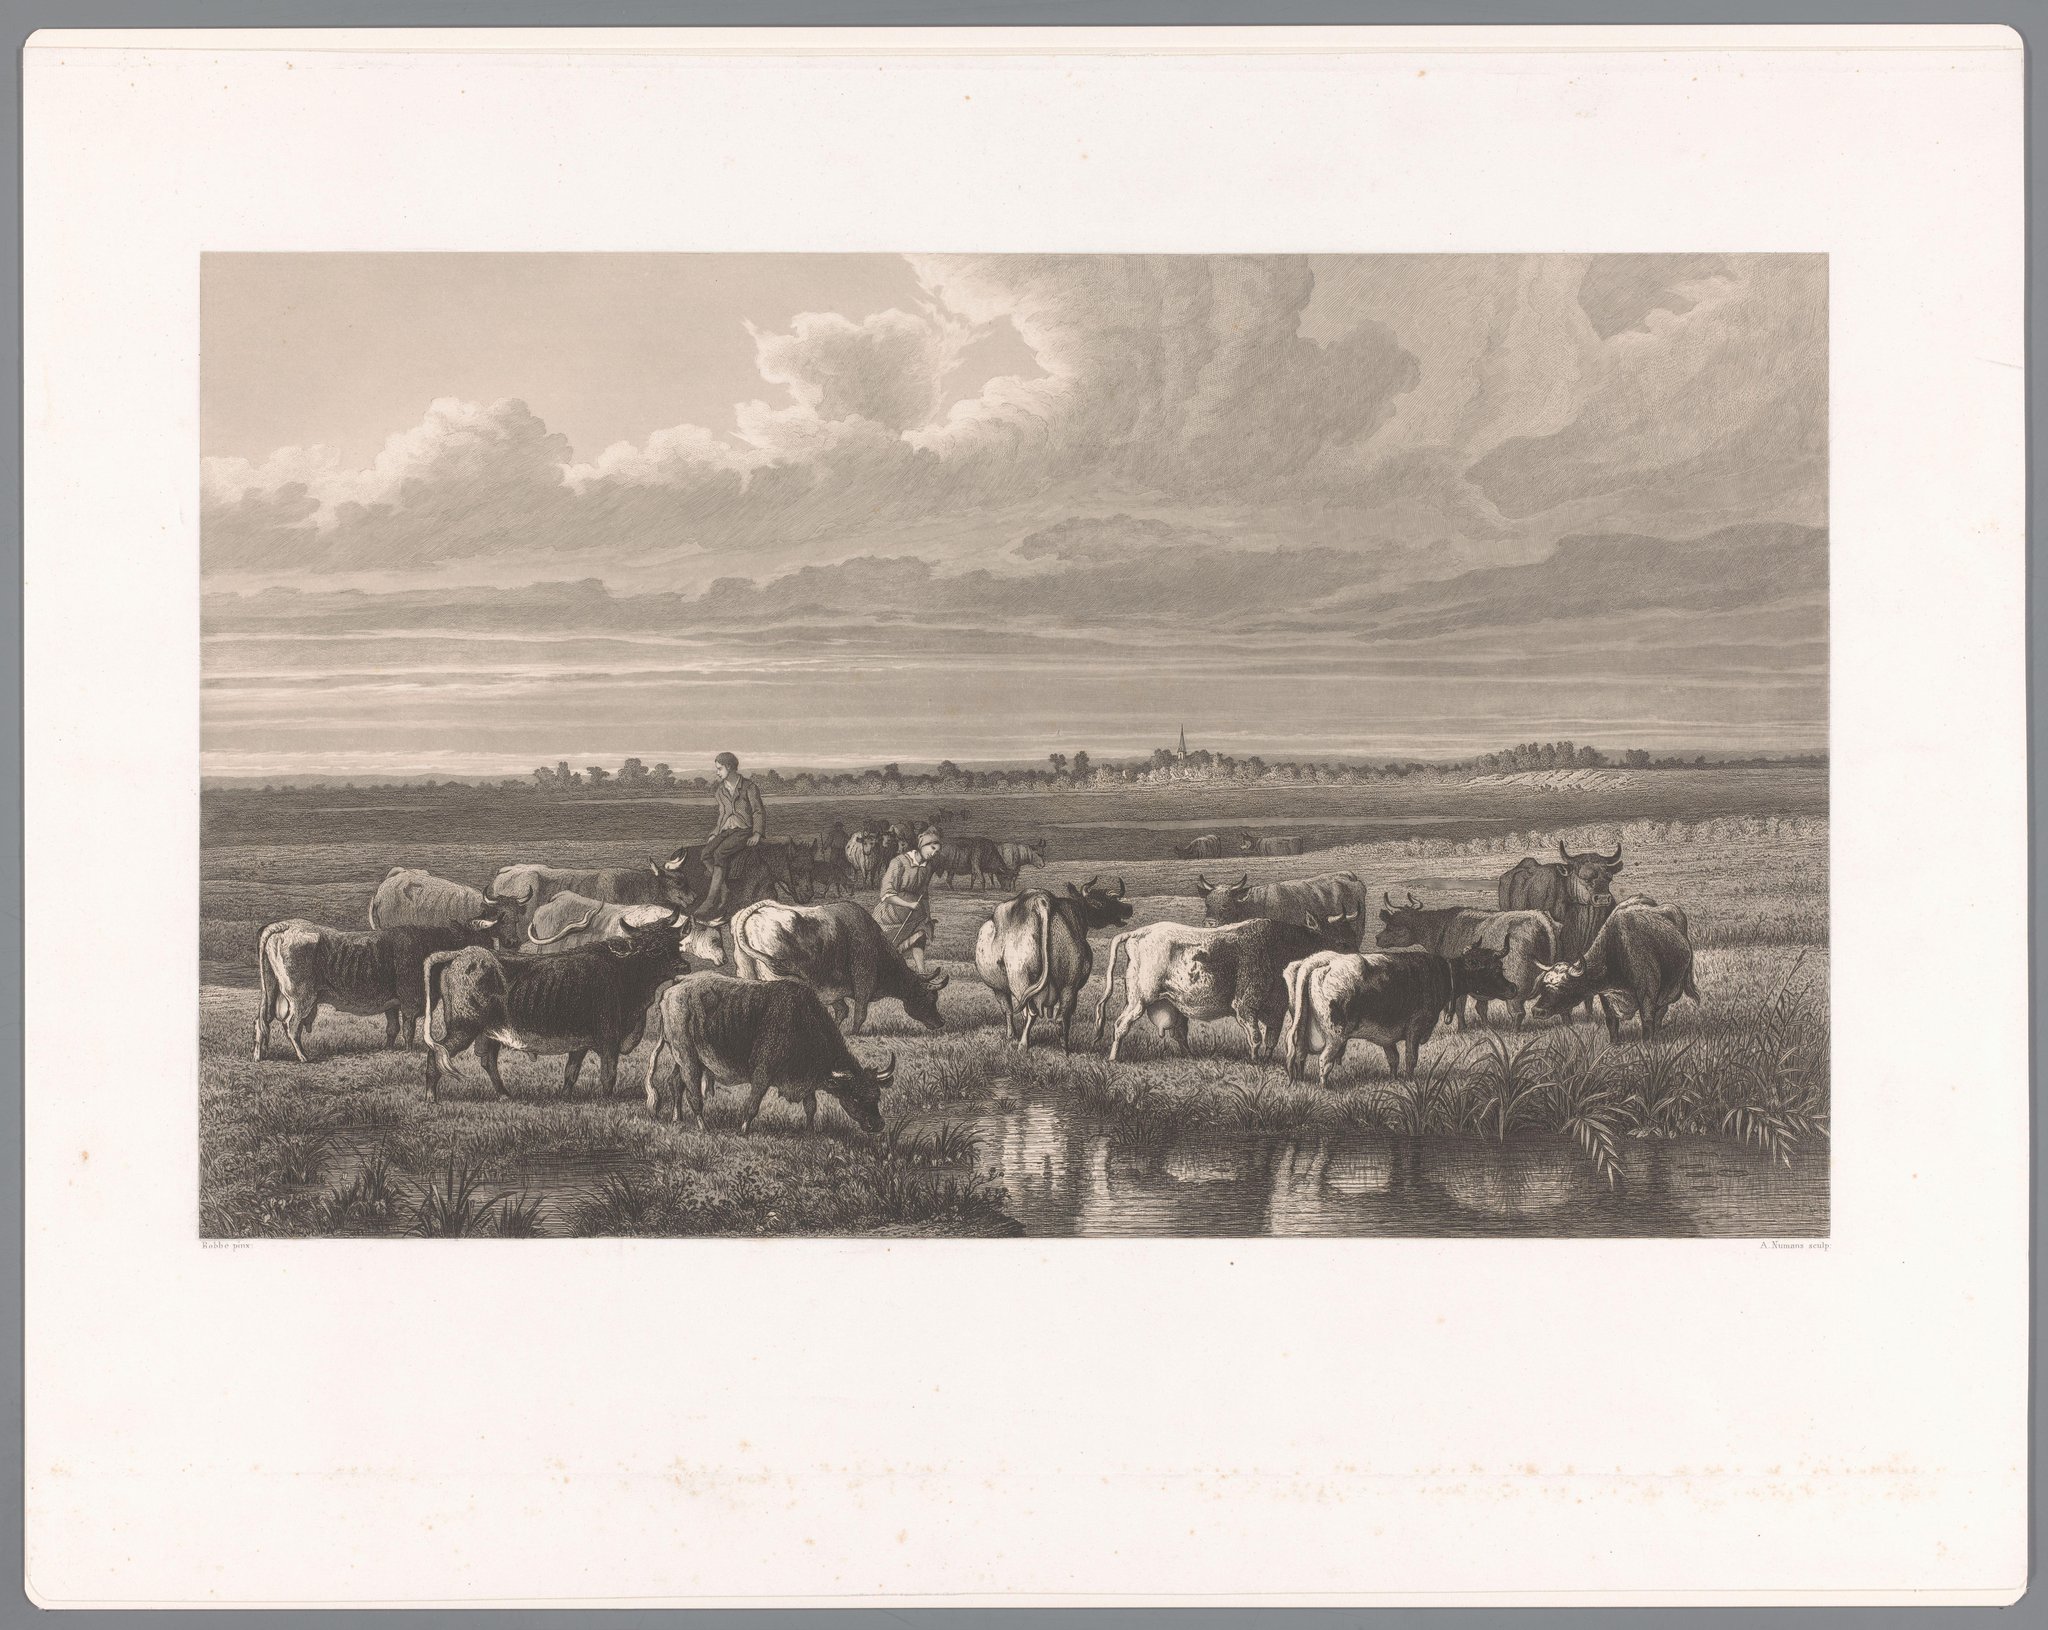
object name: print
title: Gezichten door Auguste Numans naar andere kunstenaars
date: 1833-1883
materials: paper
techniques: etching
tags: herding, herdsman, herdswoman, shepherd, shepherdess, cowherd, etc., bovine cattle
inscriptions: collector's mark: Lugt 2228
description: Prent behoort tot de prentserie: Dix eaux-fortes par A. Numans. Bij Hippert&Linnig wordt gesproken over een titelprent met de titel 'Six eaux-fortes (...)'. Waarschijnlijk gaat het om dezelfde prent als RP-P-1913-2243 want in de letter 'D' zijn contouren van een letter 'S' te zien. Mogelijk is de titelprent later aangepast om de prentserie uit te breiden van zes naar tien prenten.